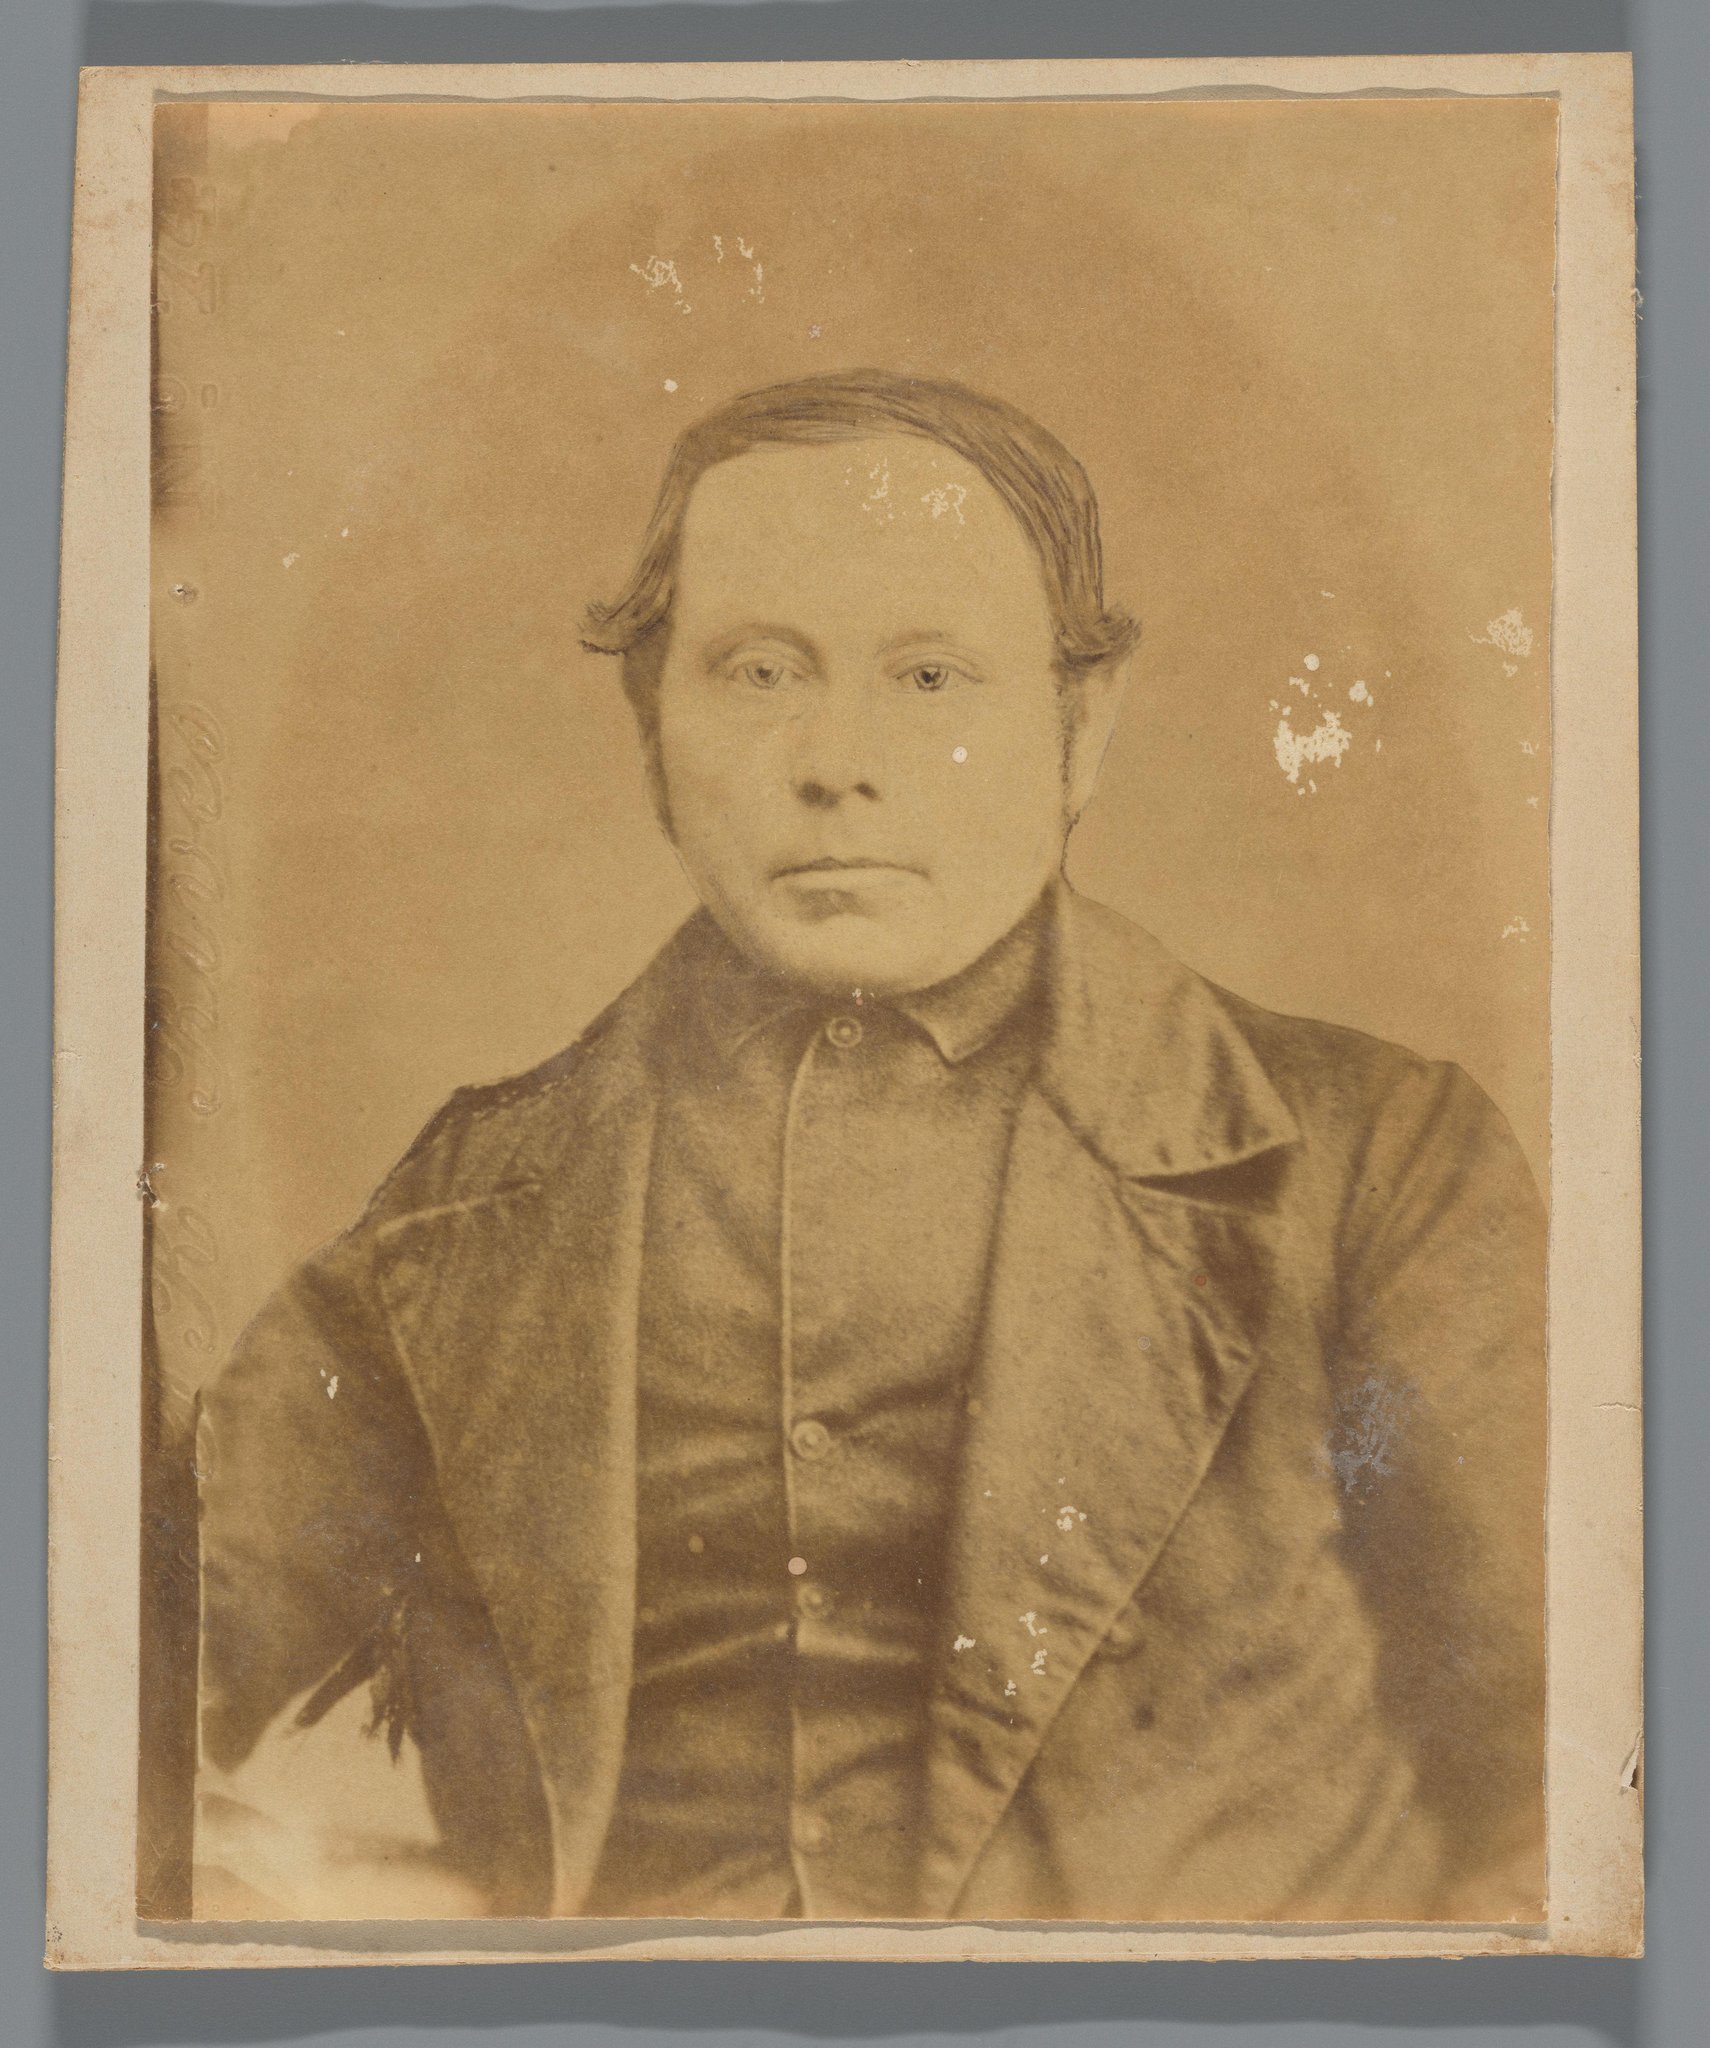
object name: photograph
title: Portret van een onbekende man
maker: Anonymous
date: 1851-1900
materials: cardboard, paper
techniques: albumen print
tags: adult man, historical persons